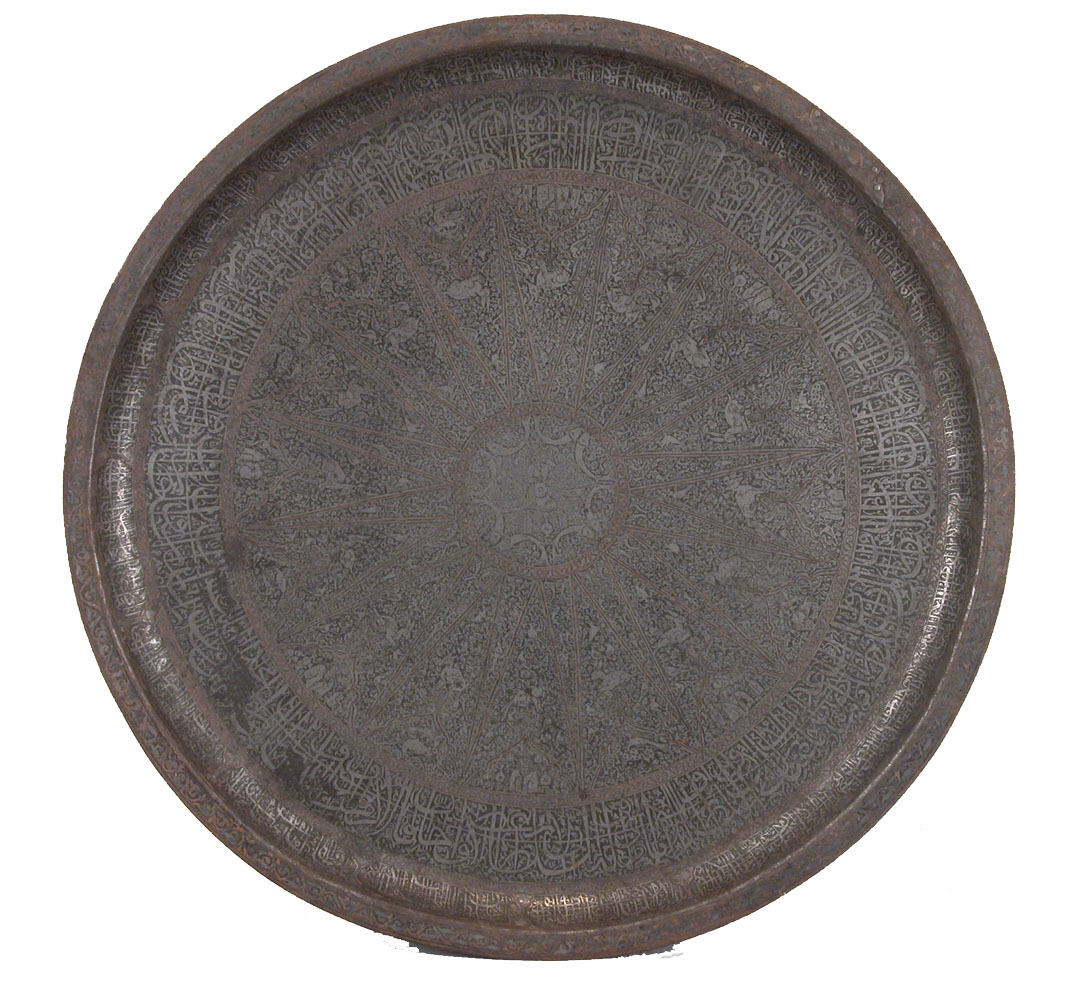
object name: tray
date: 1801-1900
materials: iron, silver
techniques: incising, inlay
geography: iran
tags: fish,musicians